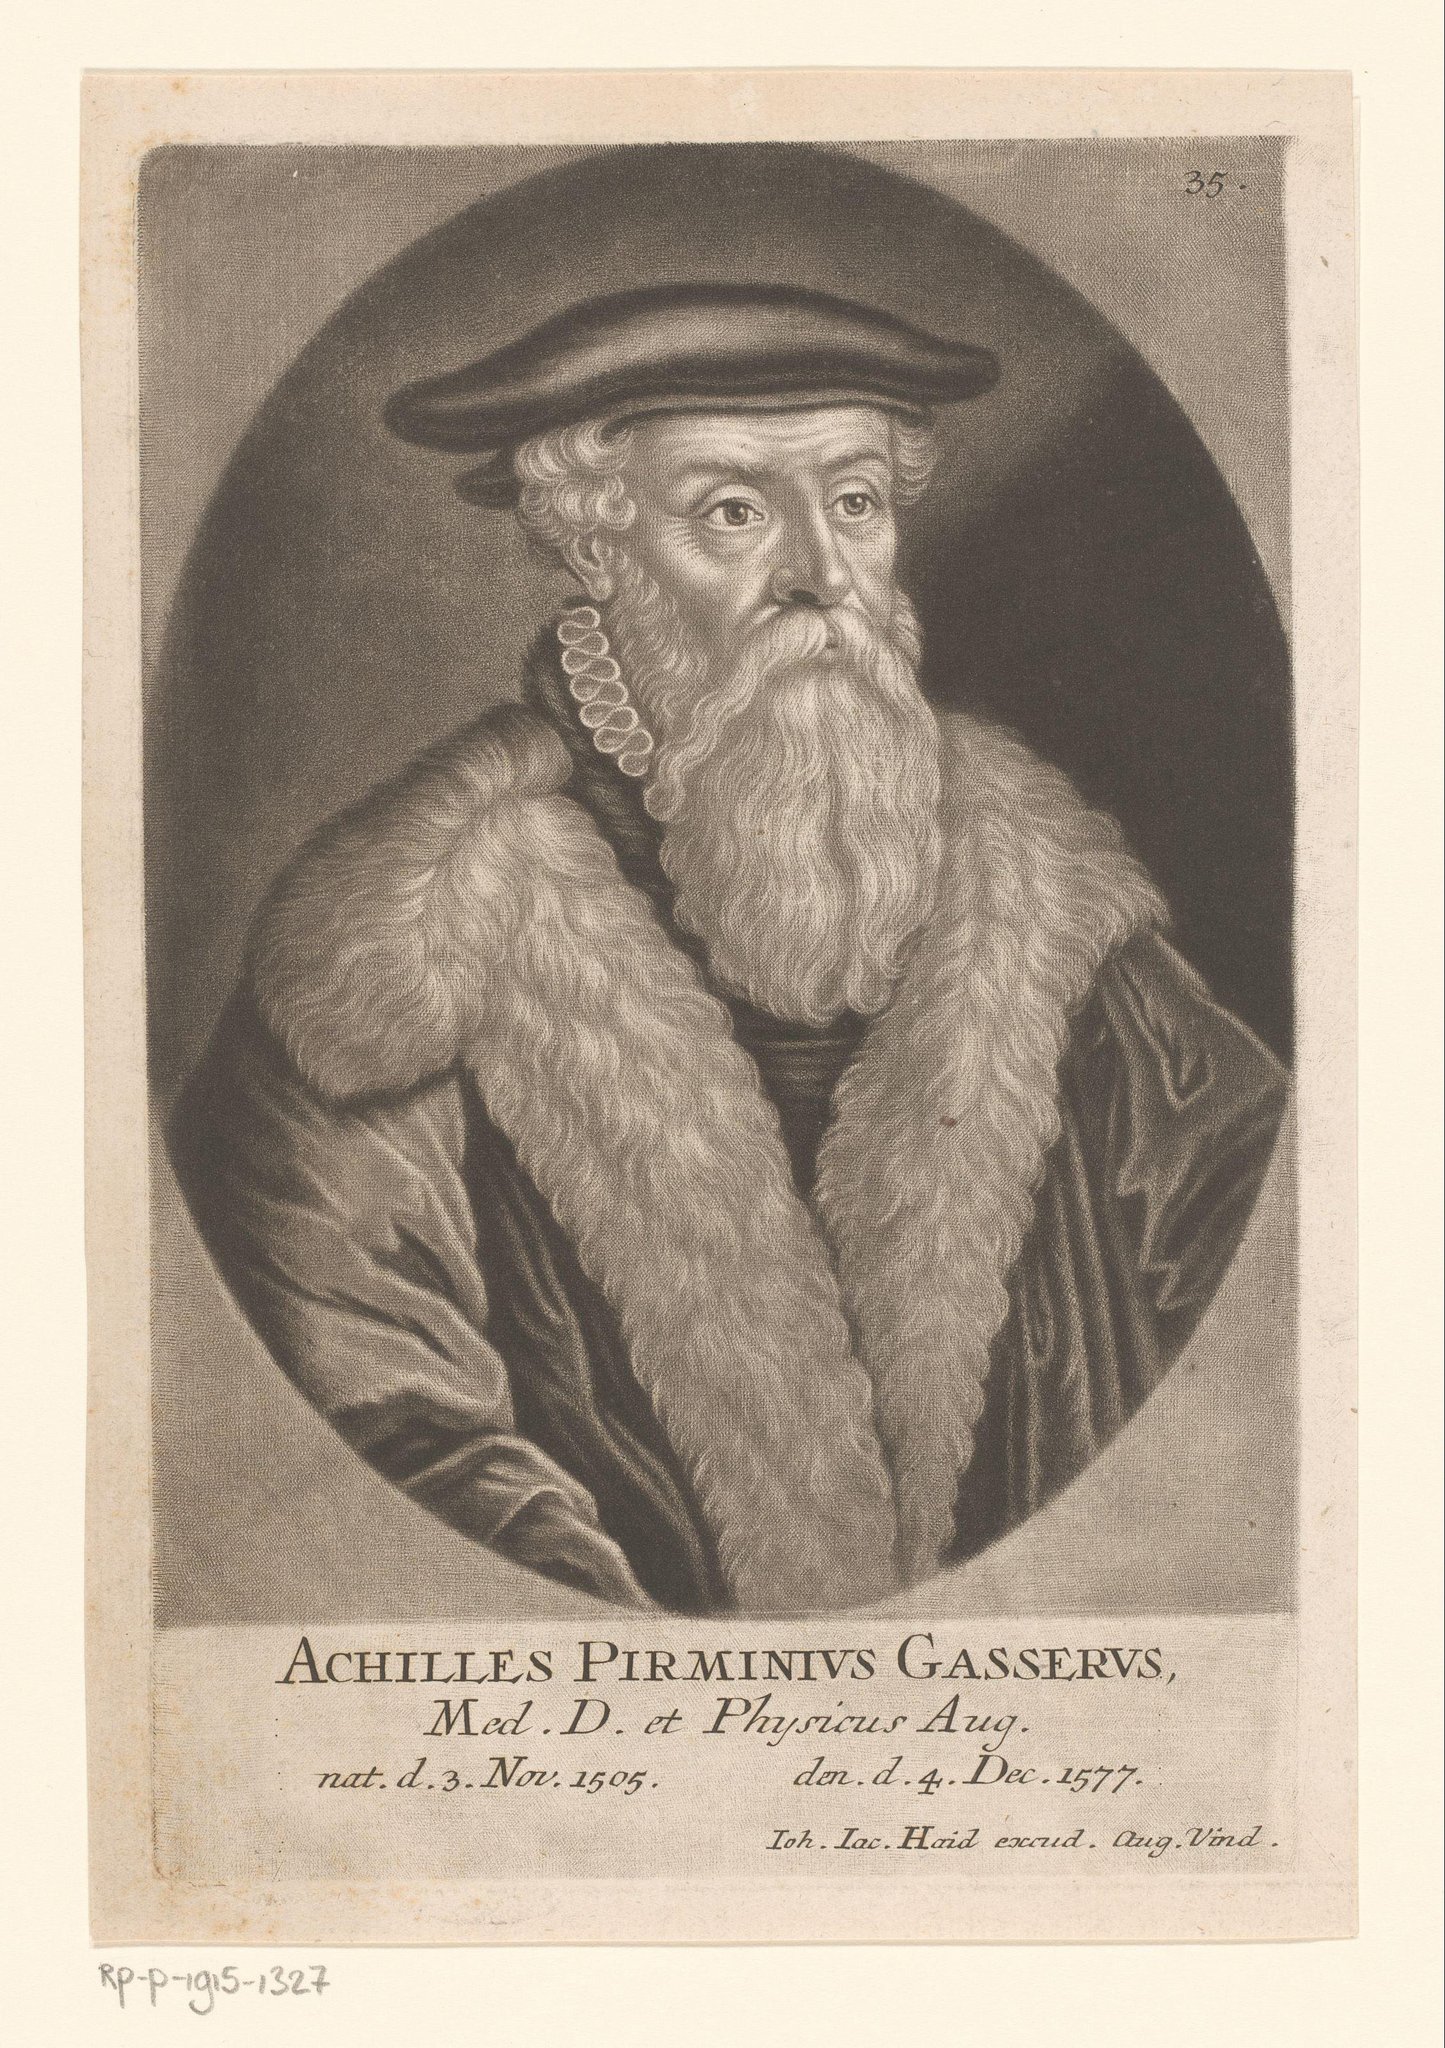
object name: print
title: Portret van Achilles Pirminius Gasser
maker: johann jacob haid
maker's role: print maker, publisher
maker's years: 1704-1767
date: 1747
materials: paper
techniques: mezzotint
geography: augsburg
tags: augsburg, physicist, historical persons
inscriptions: collector's mark: Lugt 2228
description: Prent gebruikt voor: Brucker, Jacob. Ehrentempel der Deutschen Gelehrsamkeit. Augsburg: Johann Jacob Haid, 1747.